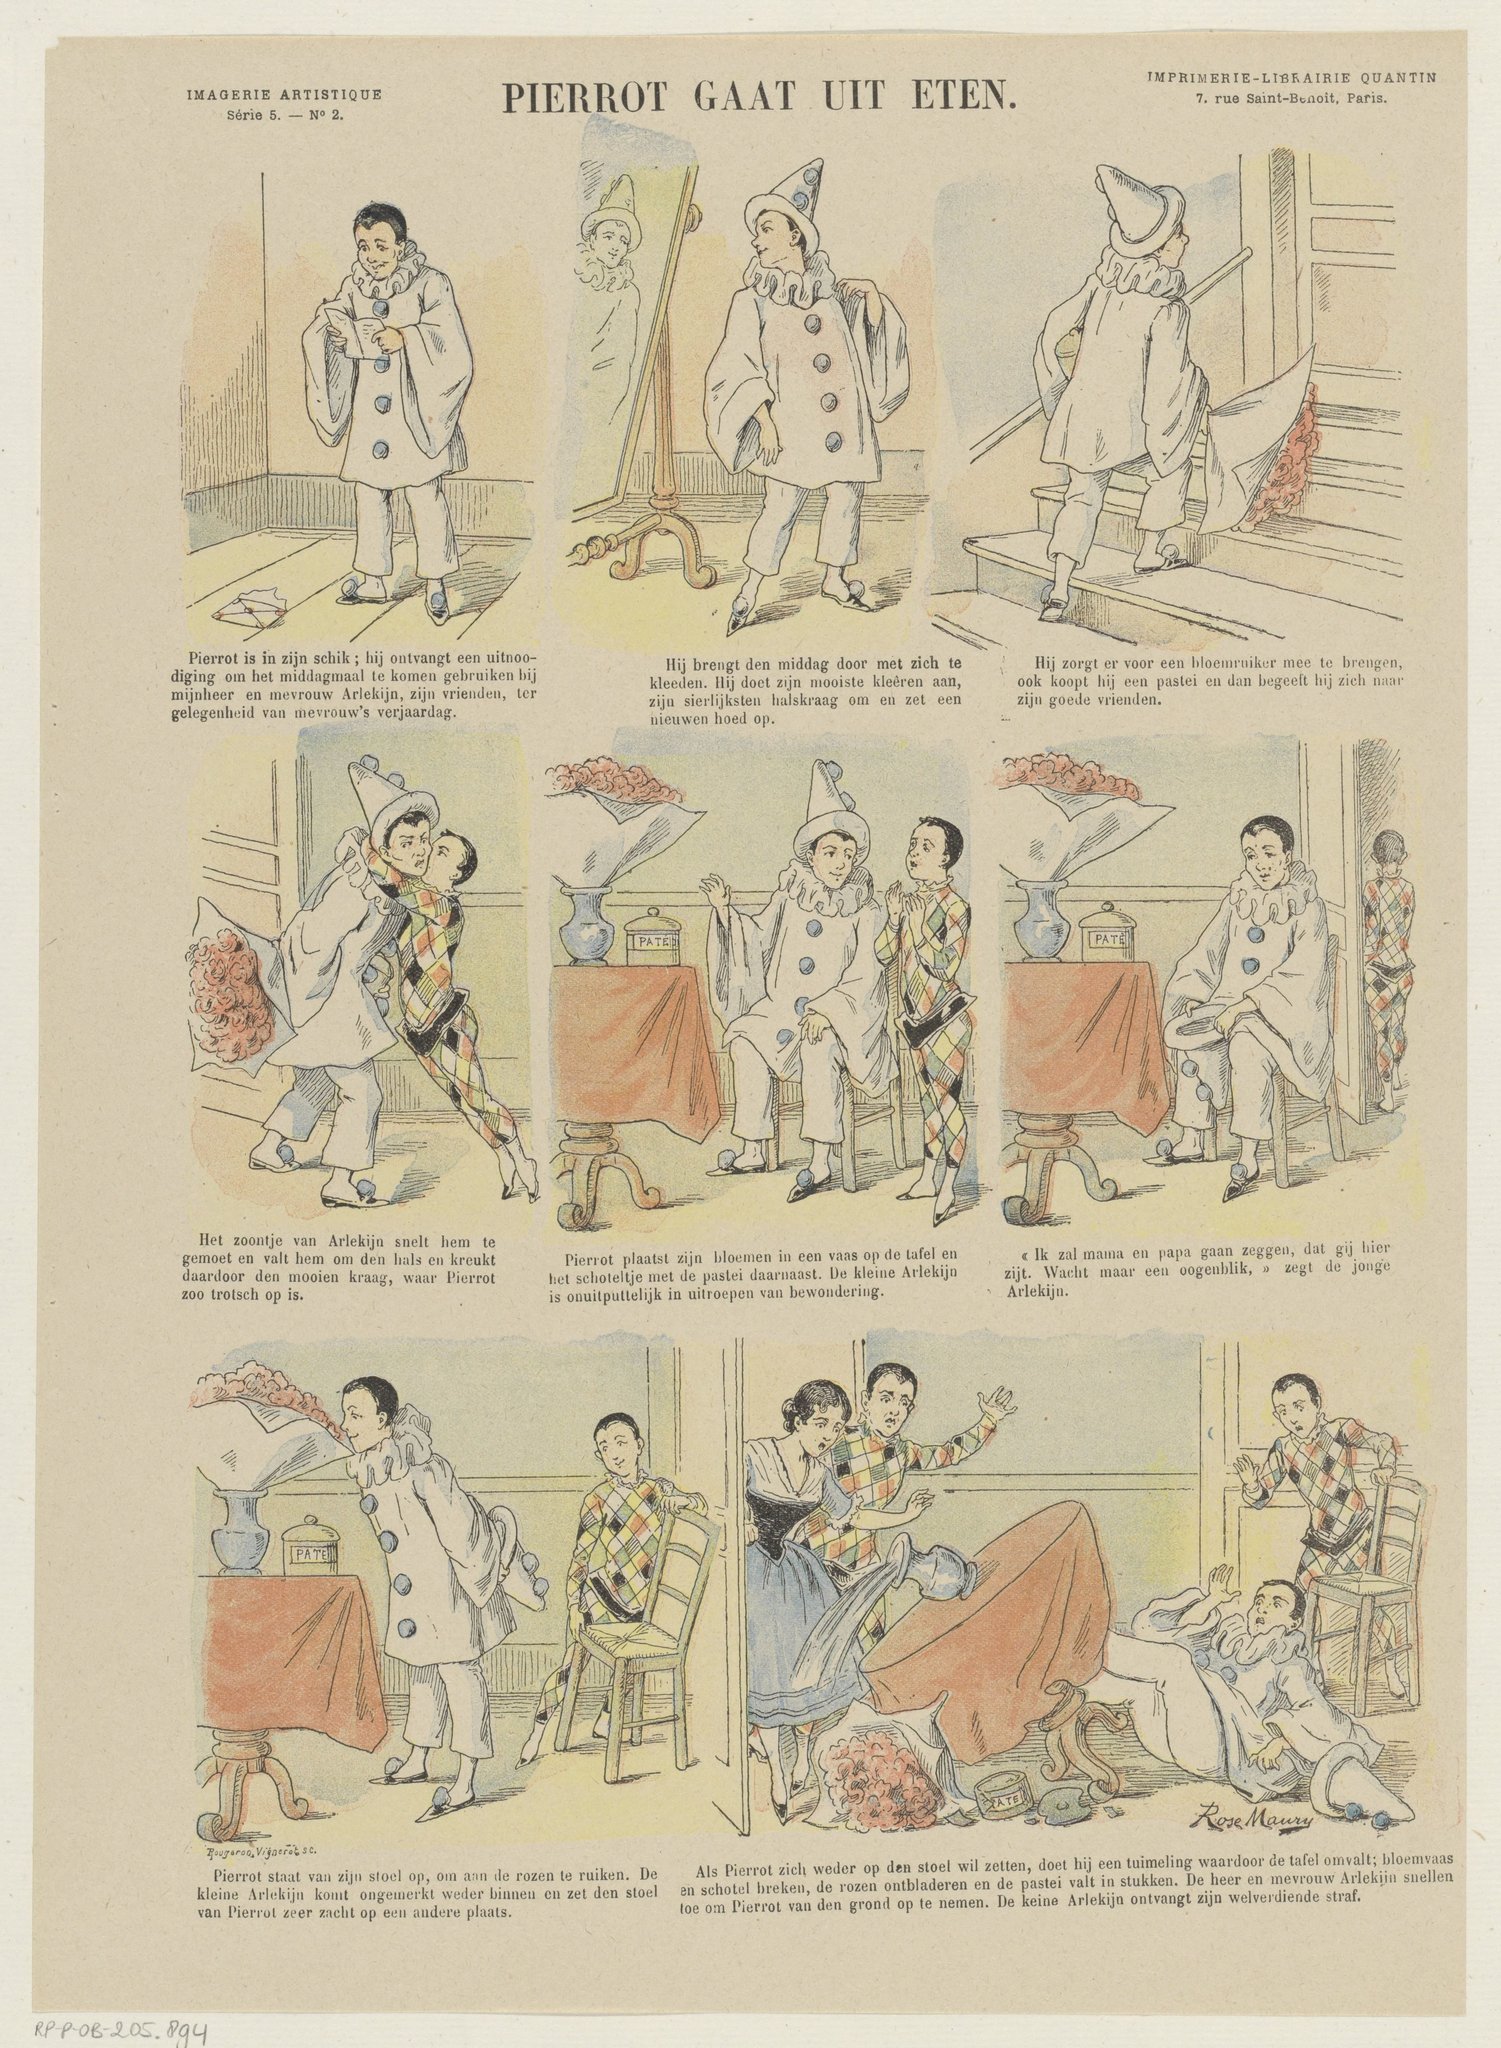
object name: print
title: Imagerie Artistique / Série 5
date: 1876-1890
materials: paper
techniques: lithograph, letterpress printing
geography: paris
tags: types in 'commedia dell'arte': pierrot, tales and fairy tales, types in 'commedia dell'arte': harlequin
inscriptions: collector's mark: Lugt 2760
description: Blad met 8 voorstellingen uit het verhaal van Pierrot die bij meneer en mevrouw Harlekijn gaat eten. Onder elke voorstelling een onderschrift. Genummerd linksboven: Série 5. - No. 2.